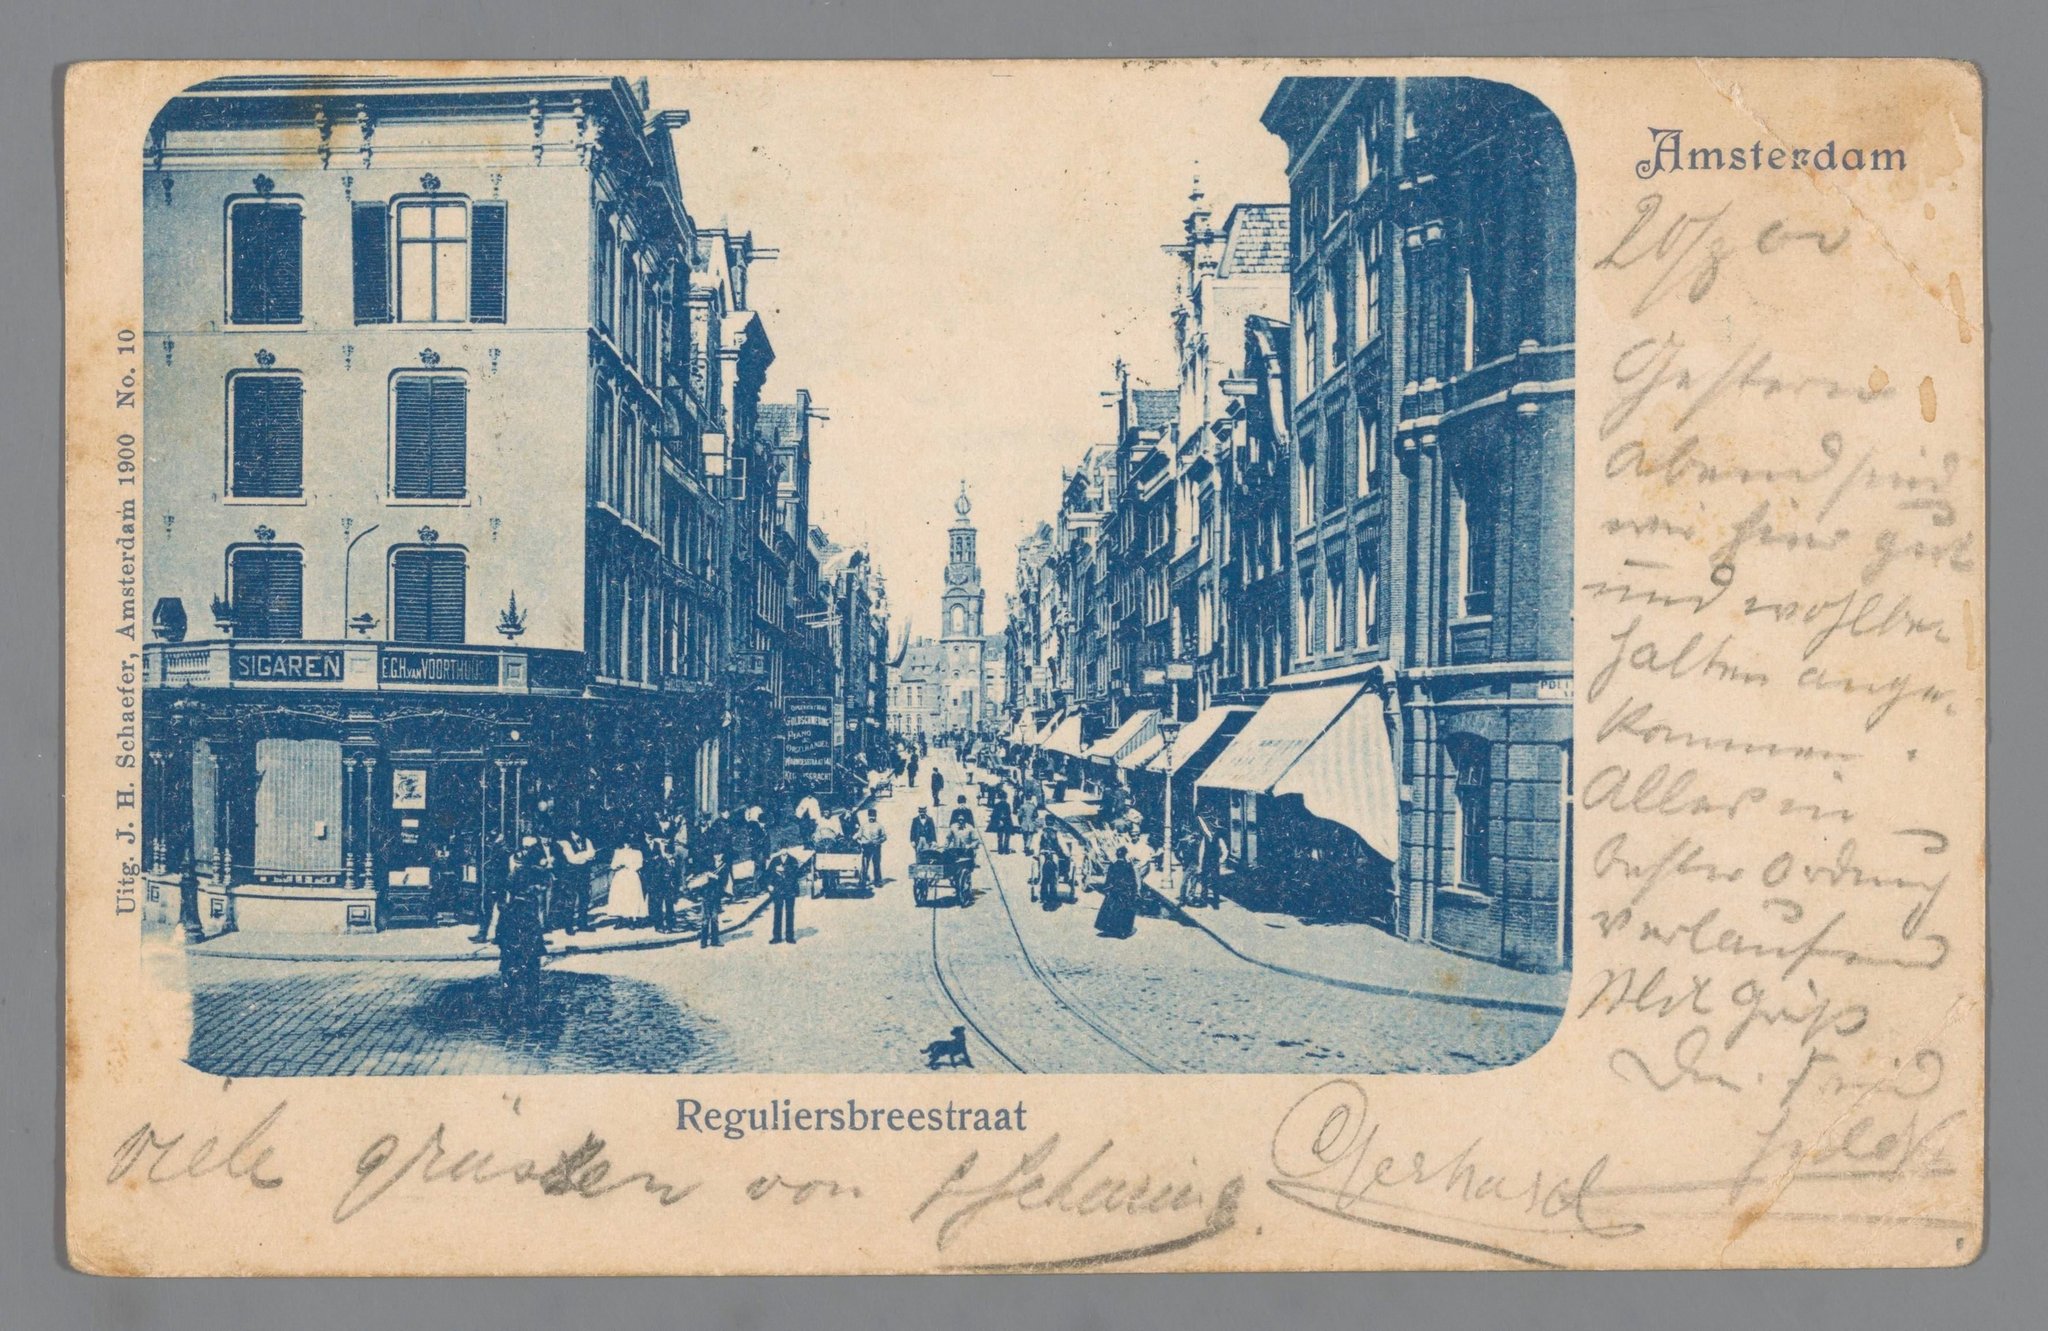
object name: photomechanical print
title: Amsterdam, Reguliersbreestraat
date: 1900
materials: cardboard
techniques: photograph, writing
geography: amsterdam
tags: street